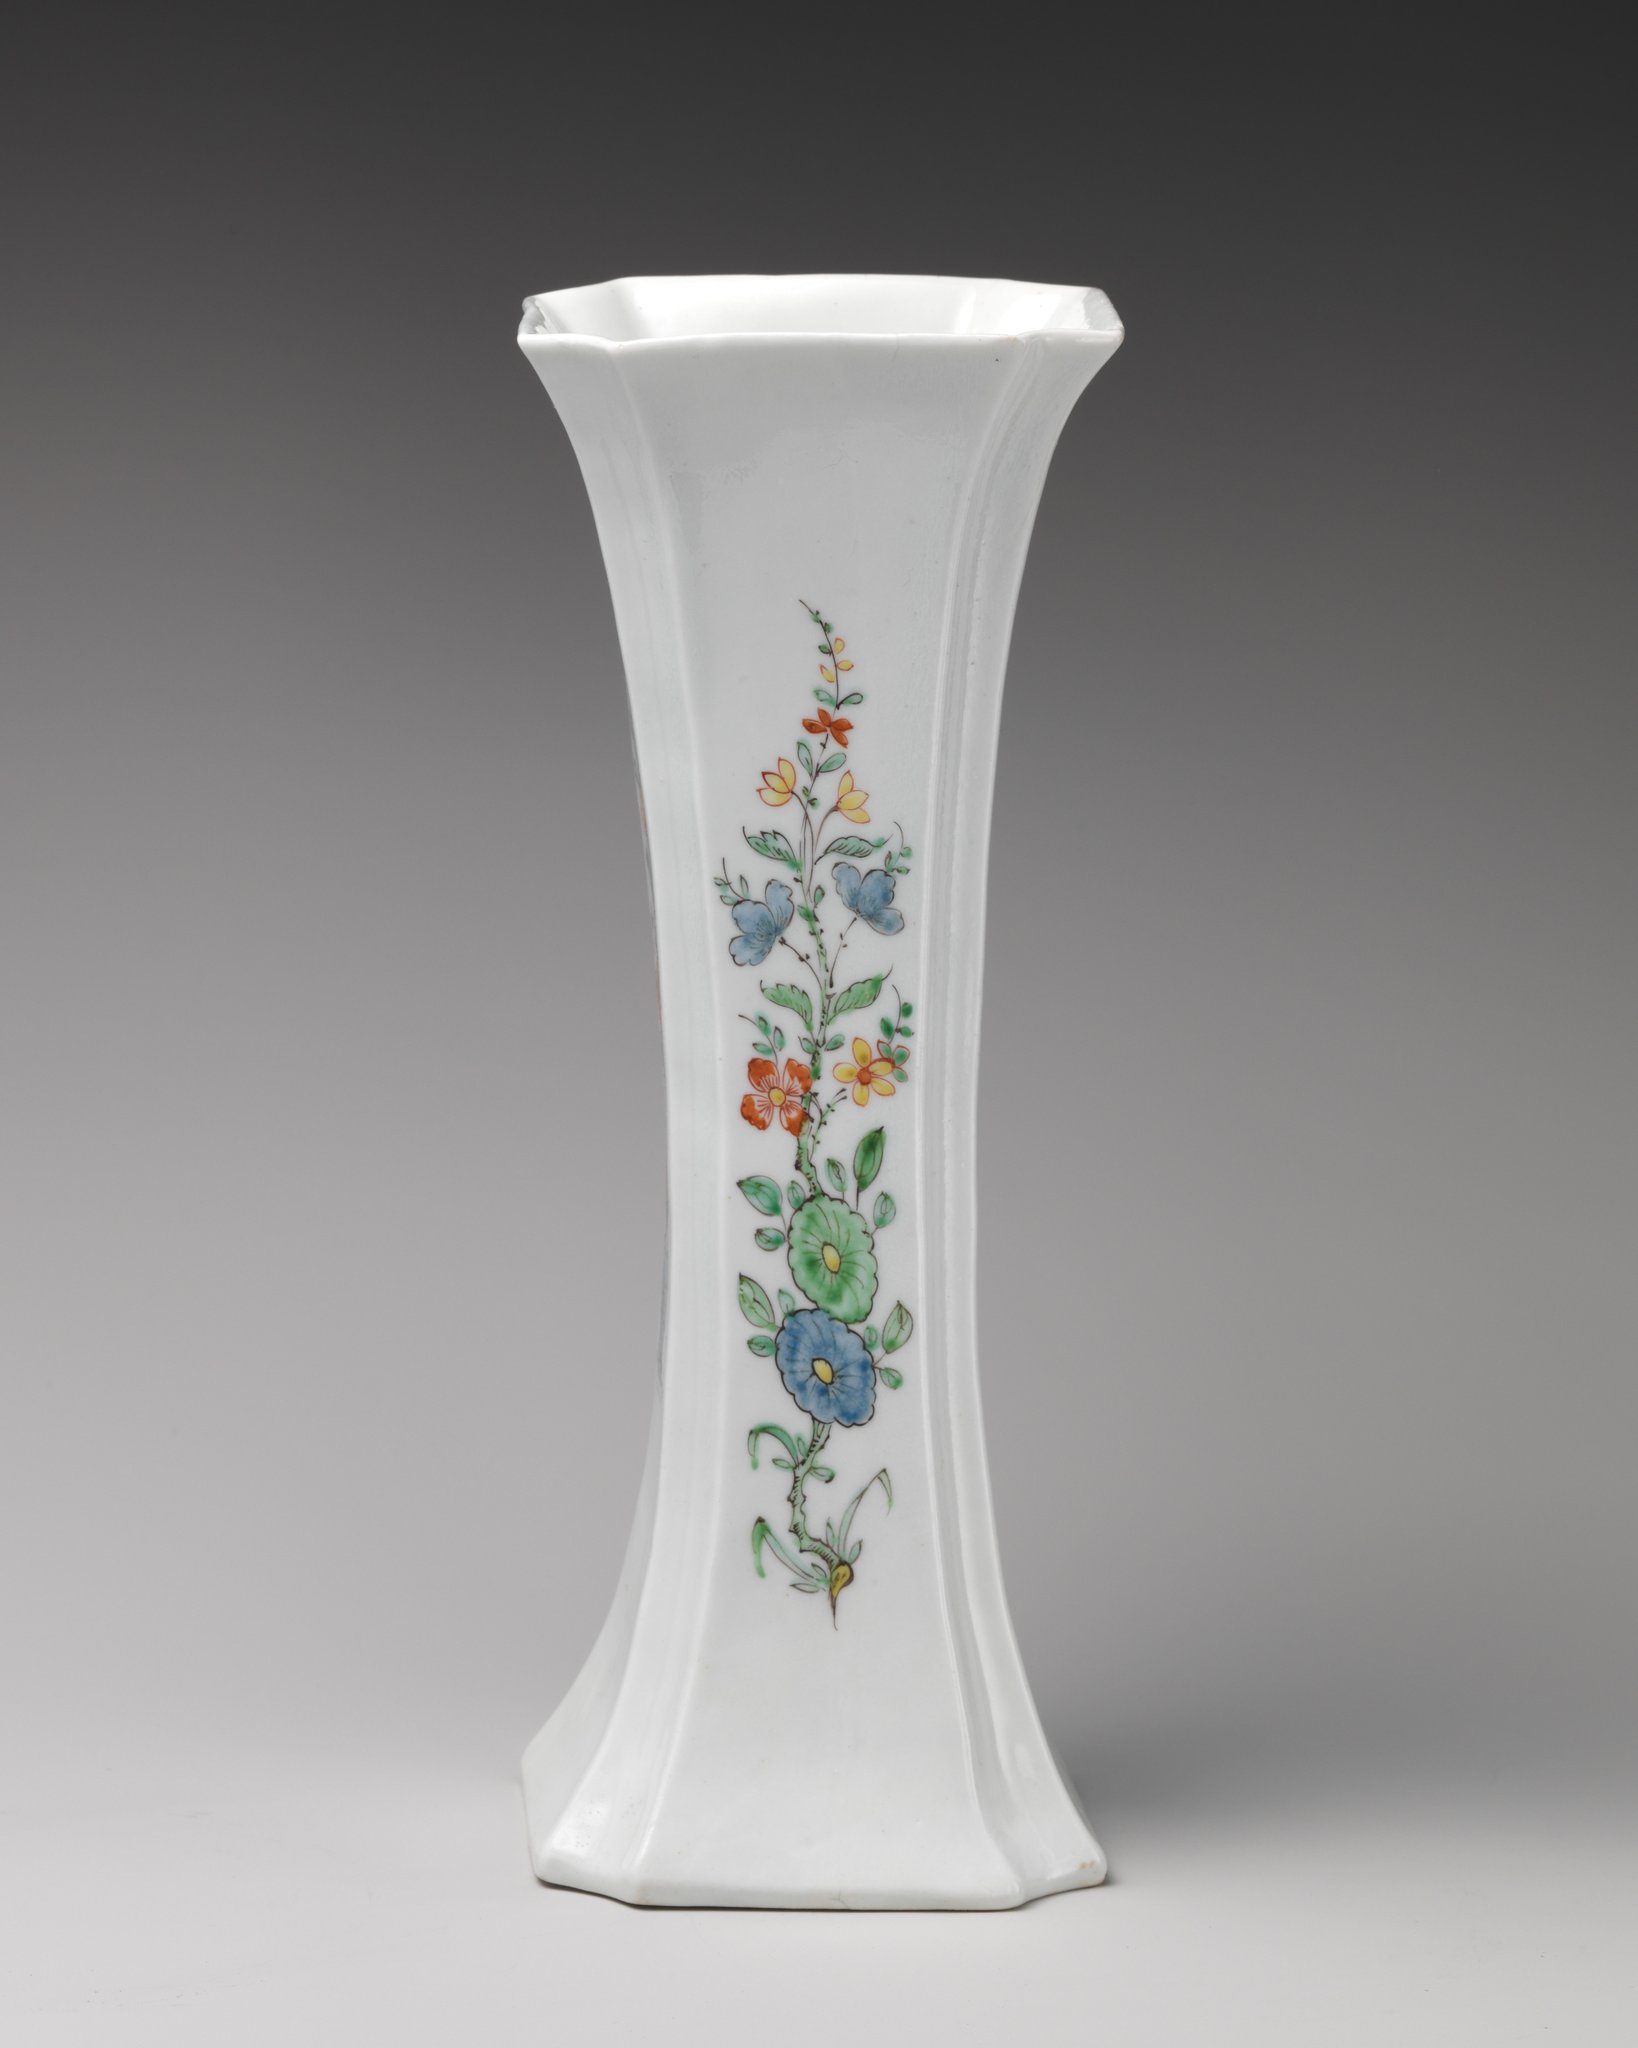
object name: garniture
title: Beaker (part of a garniture)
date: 1752-1753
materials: enamel, soft paste porcelain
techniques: polychrome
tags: flowers